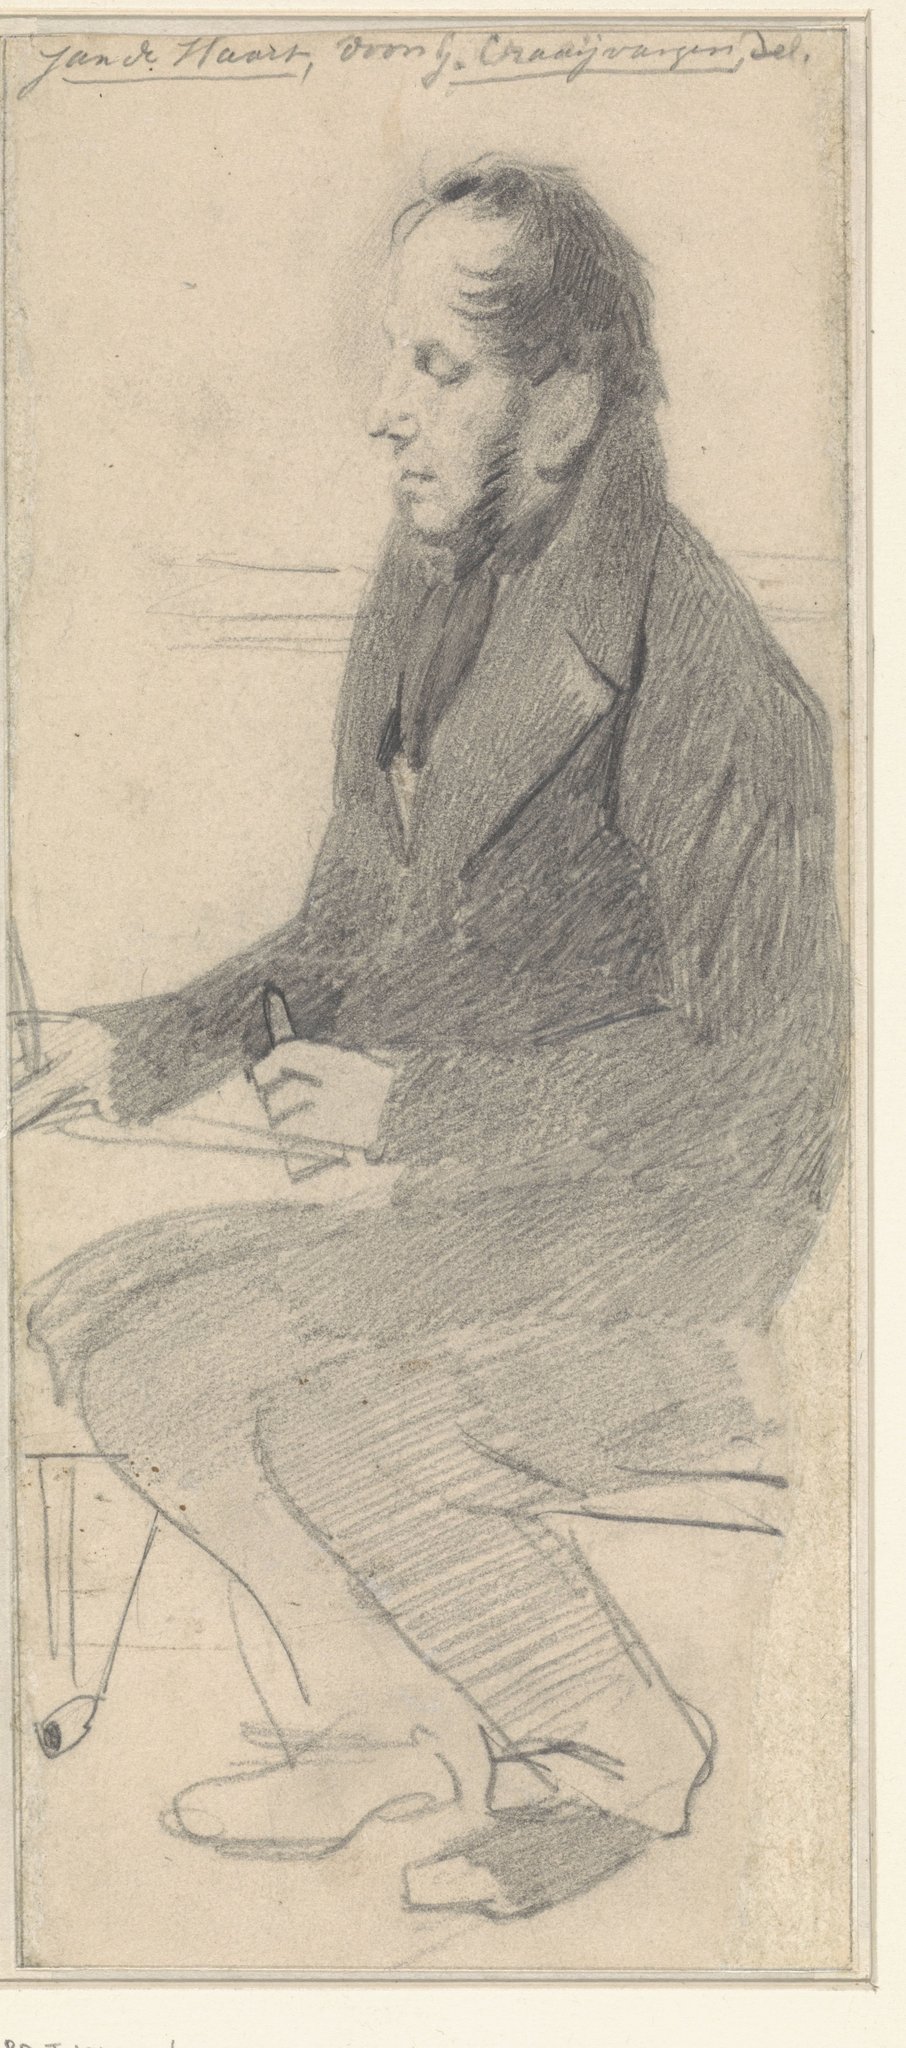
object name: drawing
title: Portret van Johannes de Haart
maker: gijsbertus craeyvanger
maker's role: draughtsman, print maker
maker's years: 1810-1895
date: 1850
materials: chalk, paper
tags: utrecht, painter, print maker, johannes de haart, historical persons, portrait, self-portrait of painter, portrait, self-portrait of artist, portrait, self-portrait of draughtsman